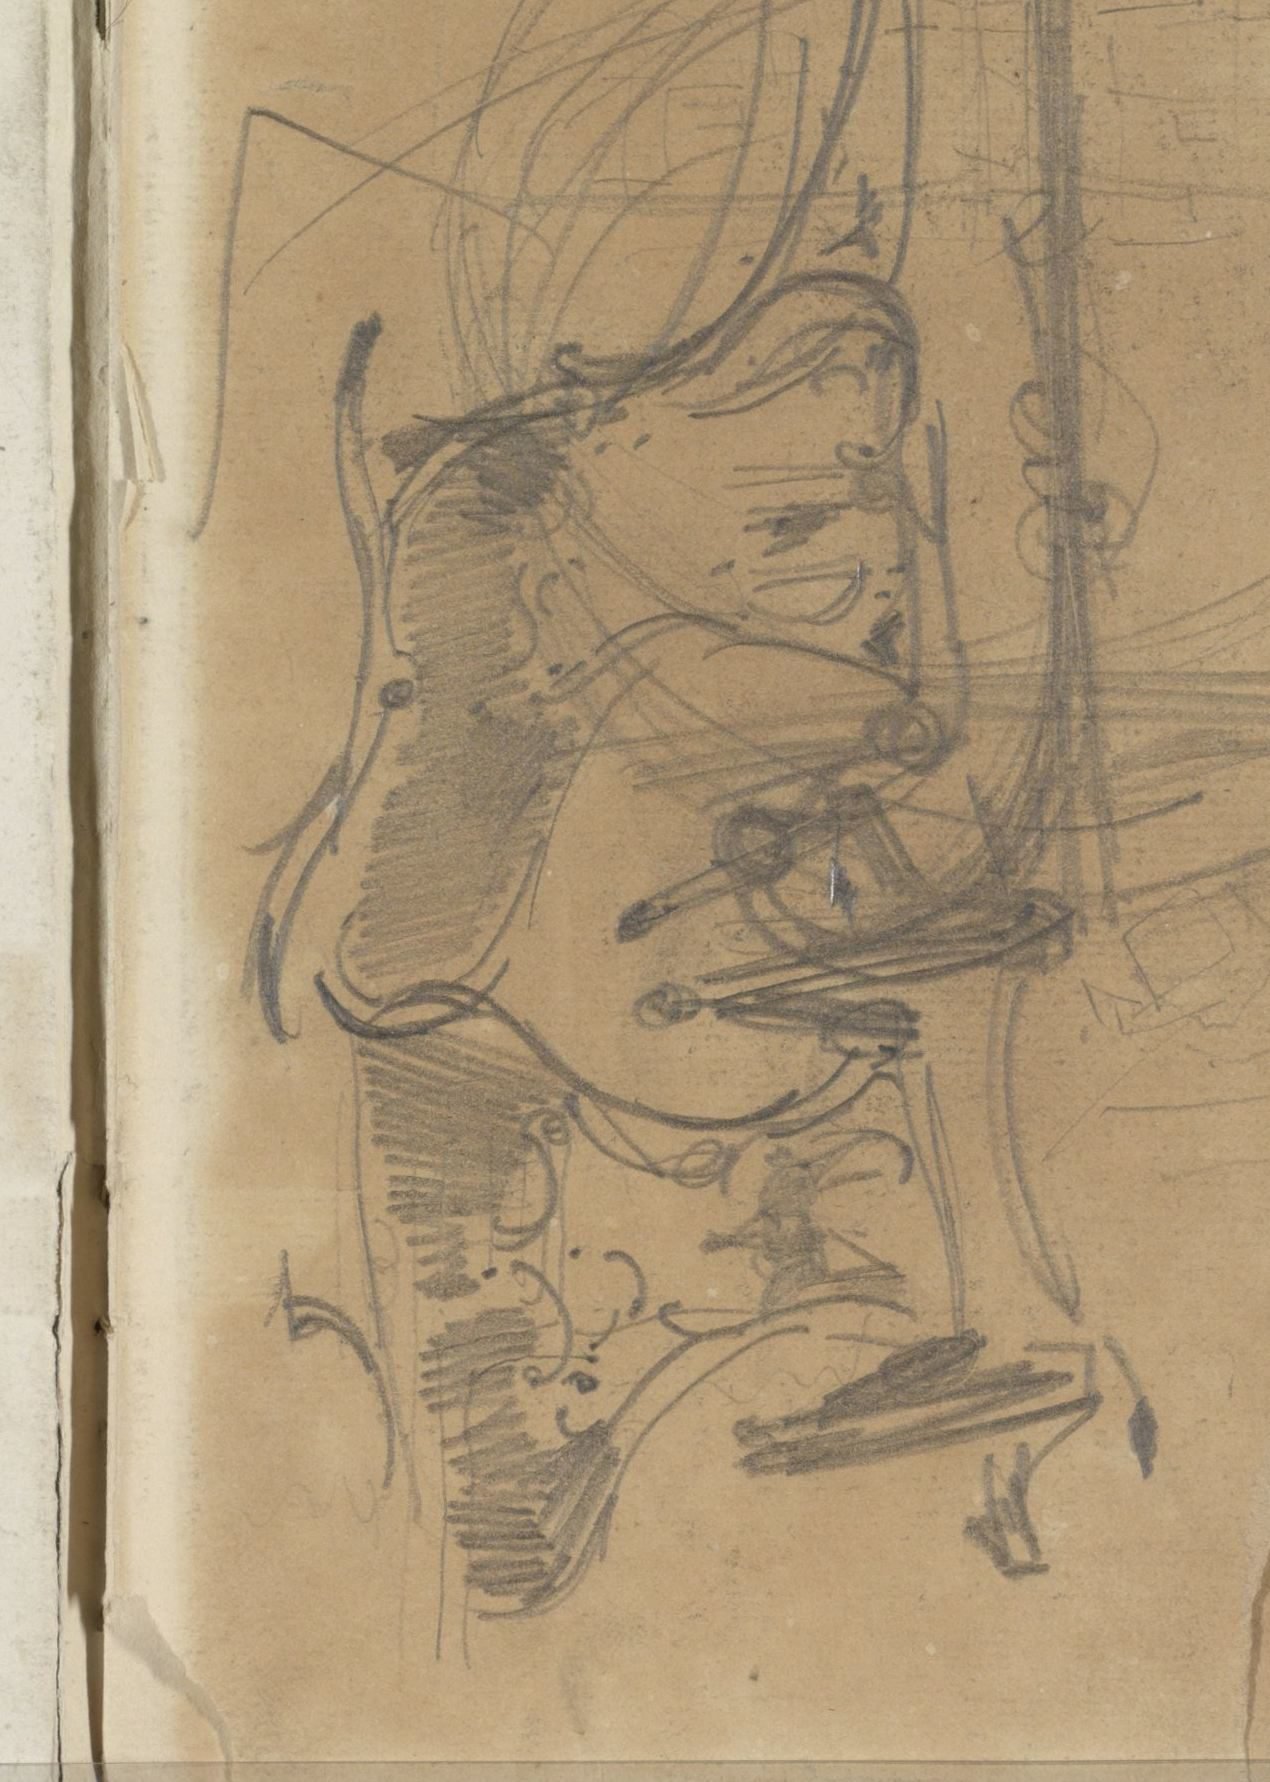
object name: sketchbook leaf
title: Studies van een slee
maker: george hendrik breitner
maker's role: draughtsman, painter, print maker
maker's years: 1857-1923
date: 1886-1923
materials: paper, pencil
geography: amsterdam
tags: sledge, sleigh (winter sports)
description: Pagina 2 uit een schetsboek met 17 bladen.